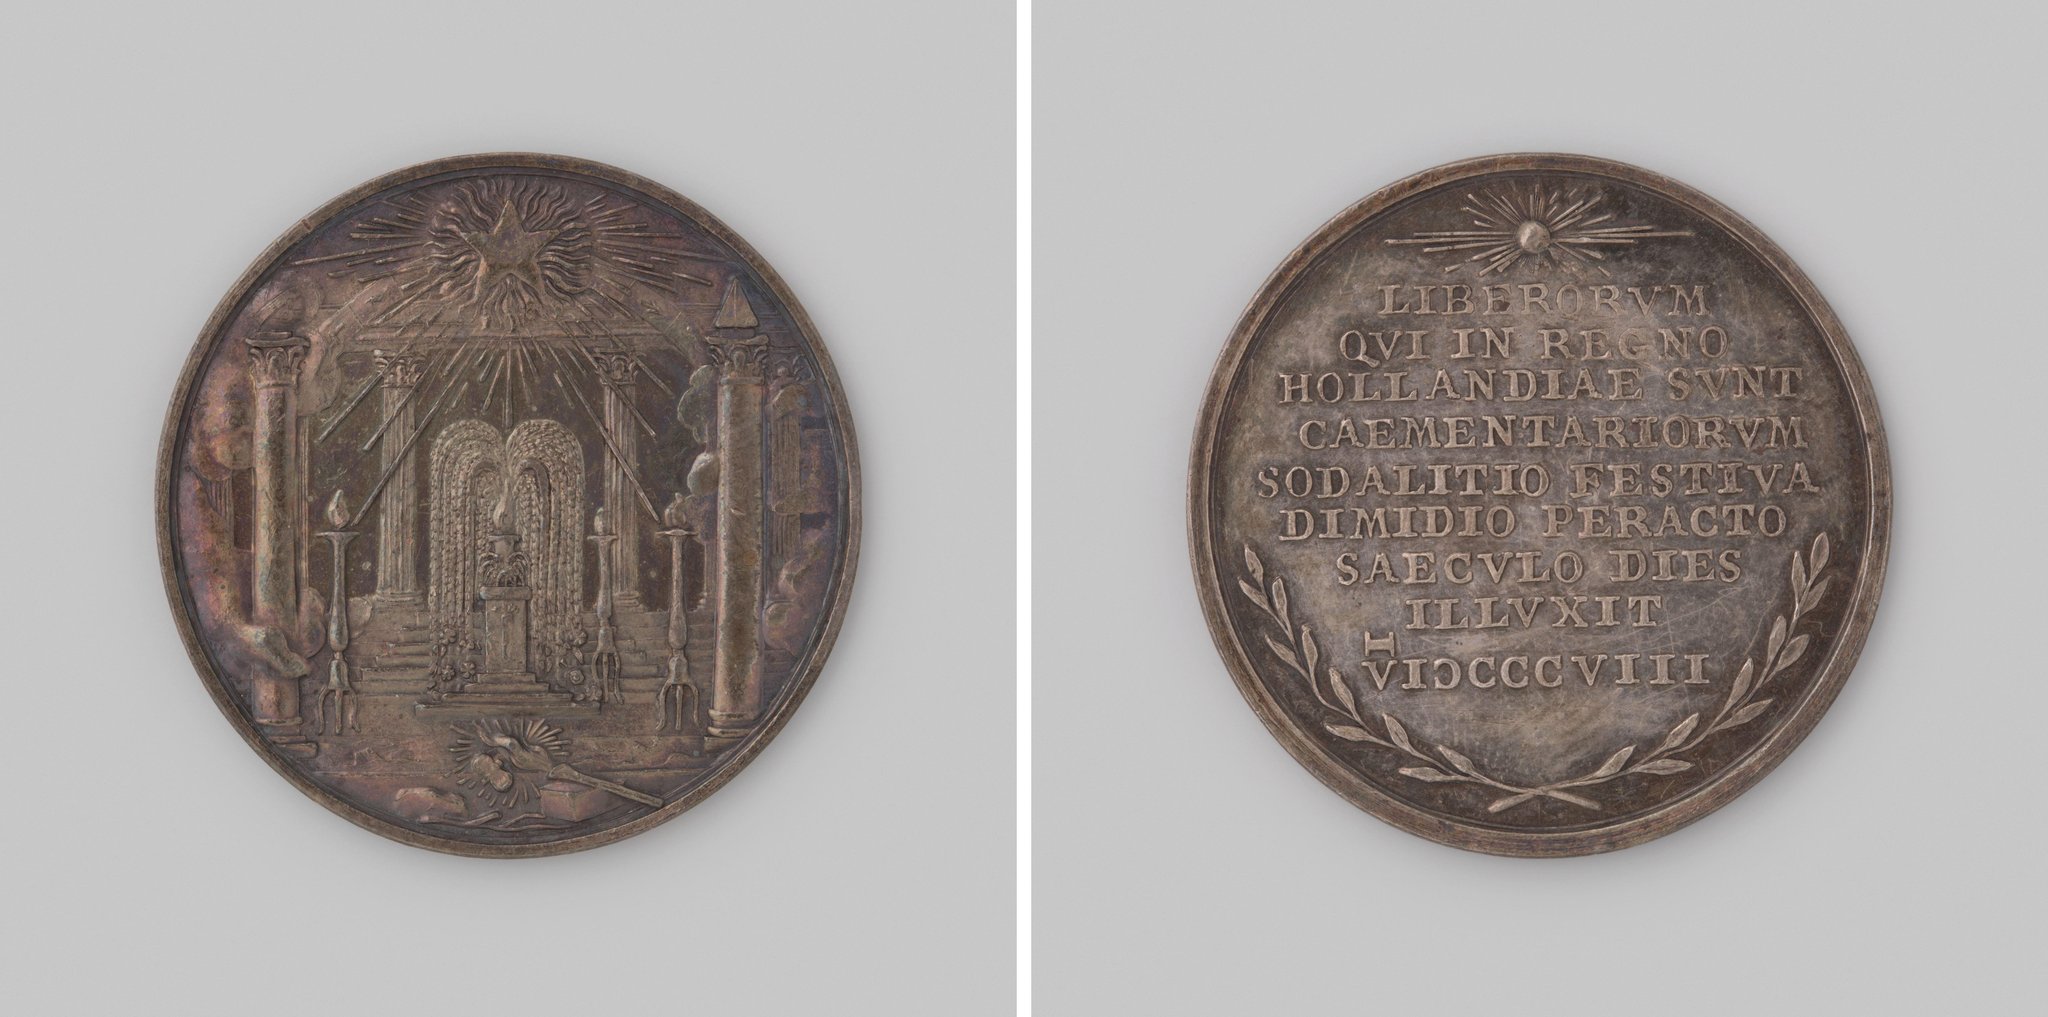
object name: history medal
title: Vijftigjarig bestaan van de Groote Loge van Bestuur in Holland 1808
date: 1808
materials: silver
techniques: striking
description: Zilveren penning, op de keerzijde een stralende zon en negen regels tekst boven twee lauwertakken.